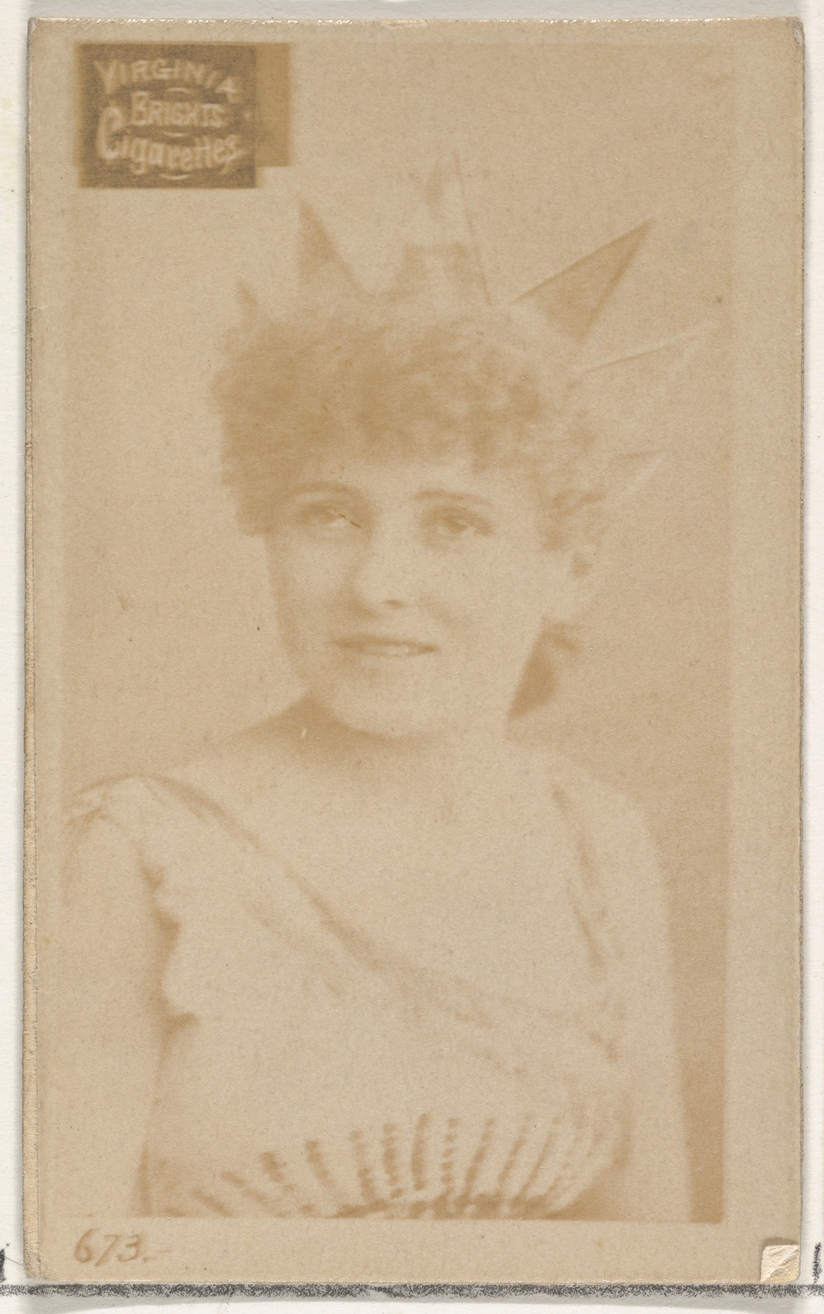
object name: photograph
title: Card 673, from the Actors and Actresses series (N45, Type 2) for Virginia Brights Cigarettes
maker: allen & ginter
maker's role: publisher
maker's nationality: american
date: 1888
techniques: albumen silver print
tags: portraits,women,actresses